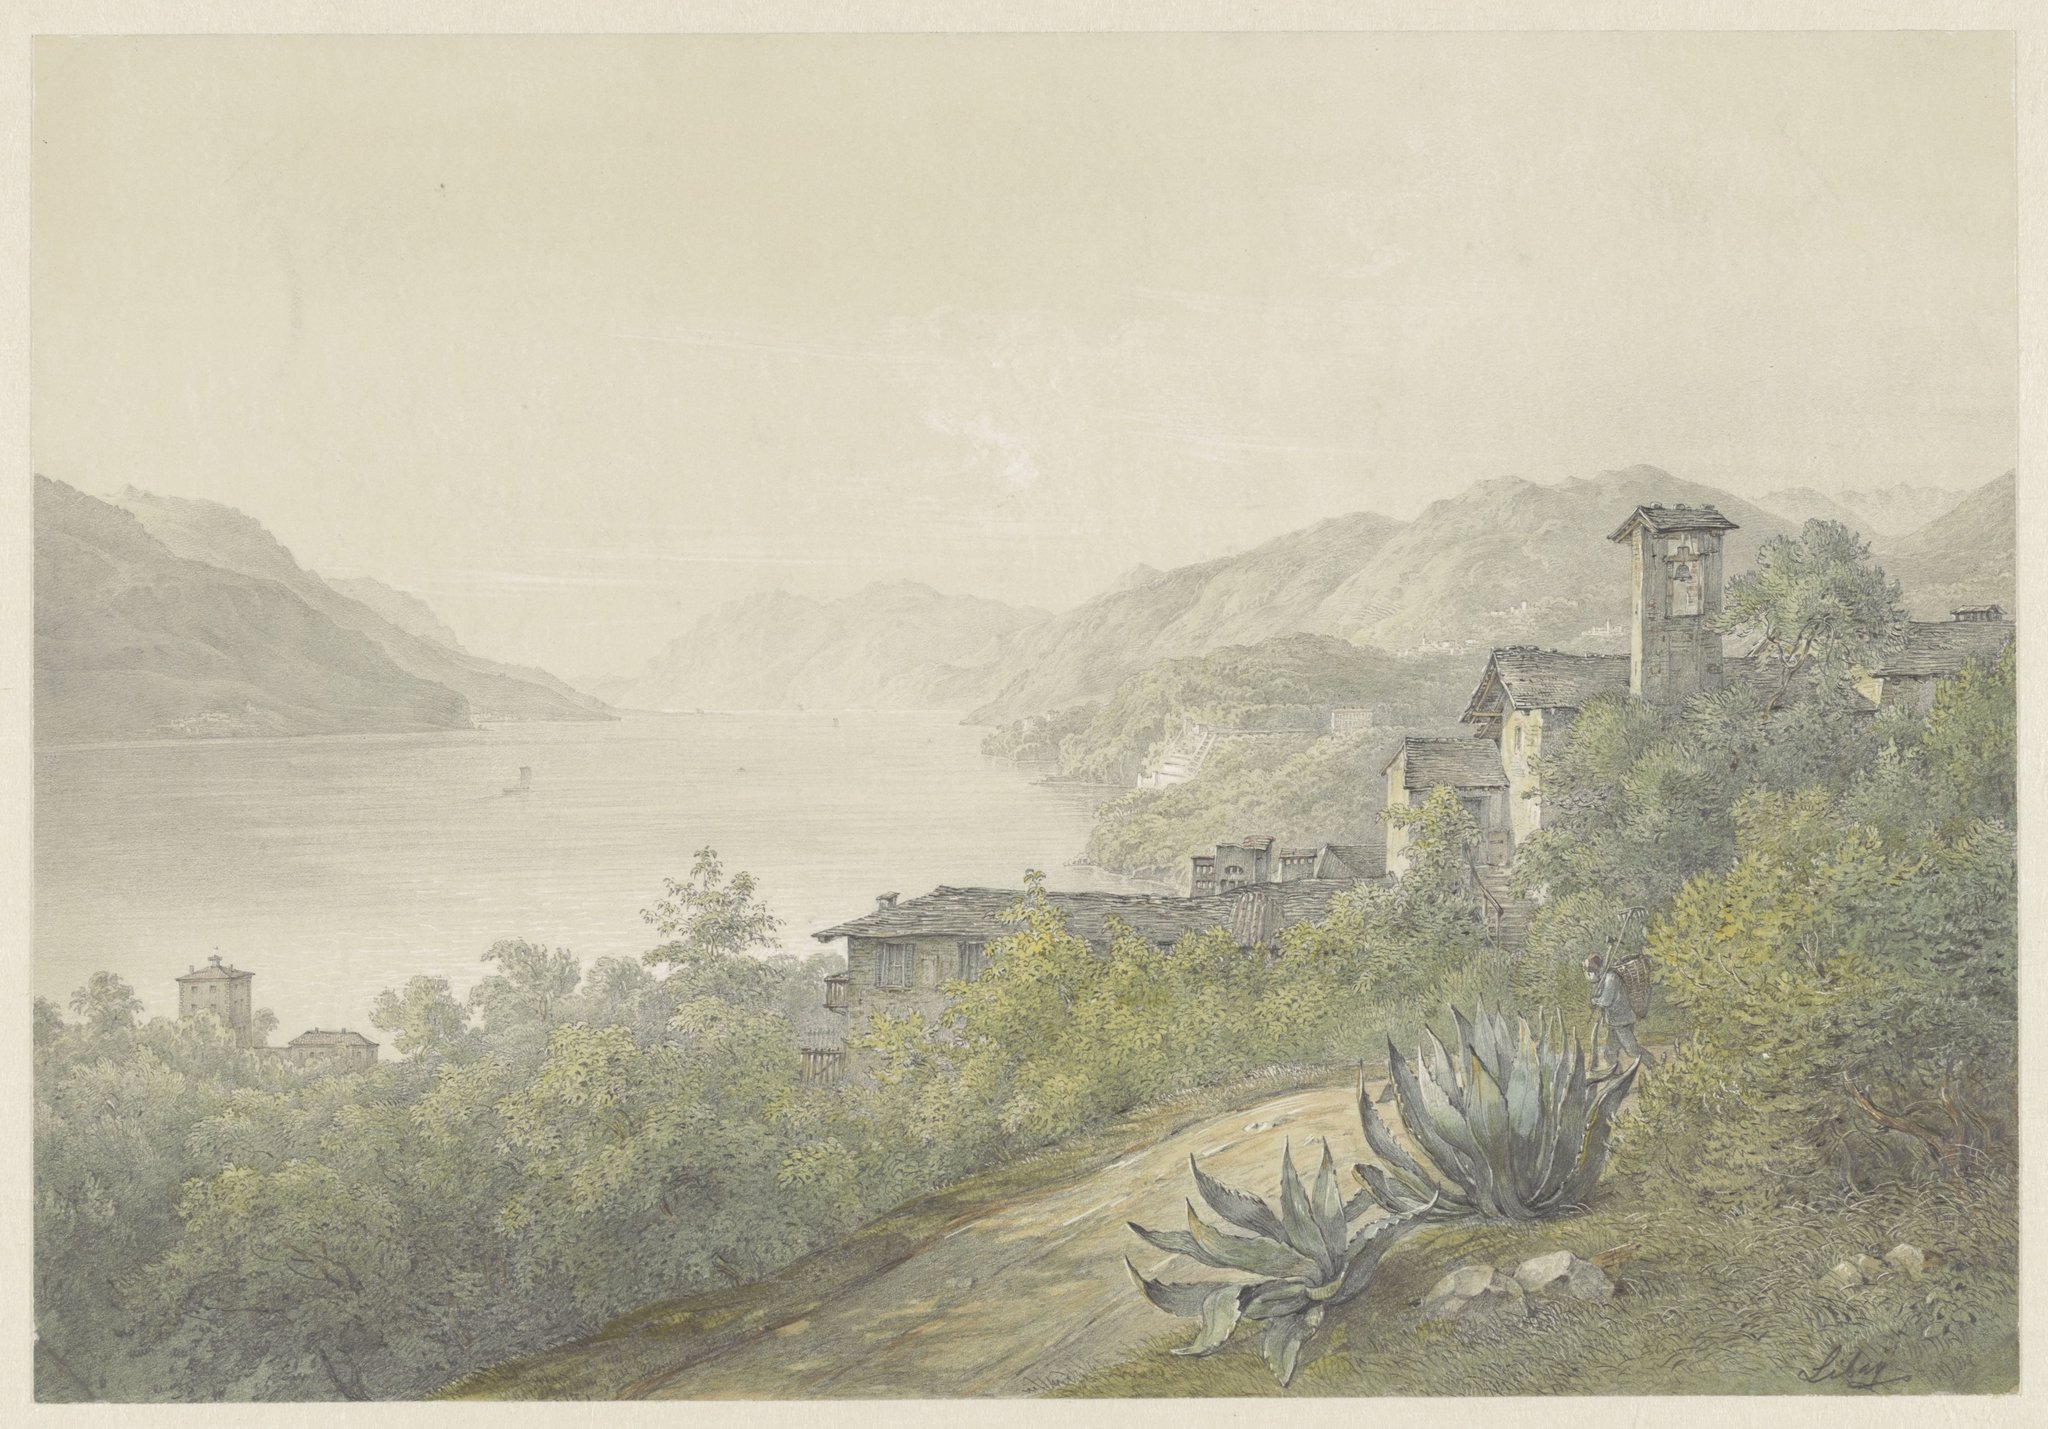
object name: drawing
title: Gezicht vanuit het park van Bellagio, aan het Comomeer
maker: karoly lajos libay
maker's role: draughtsman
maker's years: 1814-1888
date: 1824-1888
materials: cardboard, pencil, watercolor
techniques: brush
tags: lake, prospect of city, town panorama, silhouette of city (+ city(-scape) with figures, staffage)